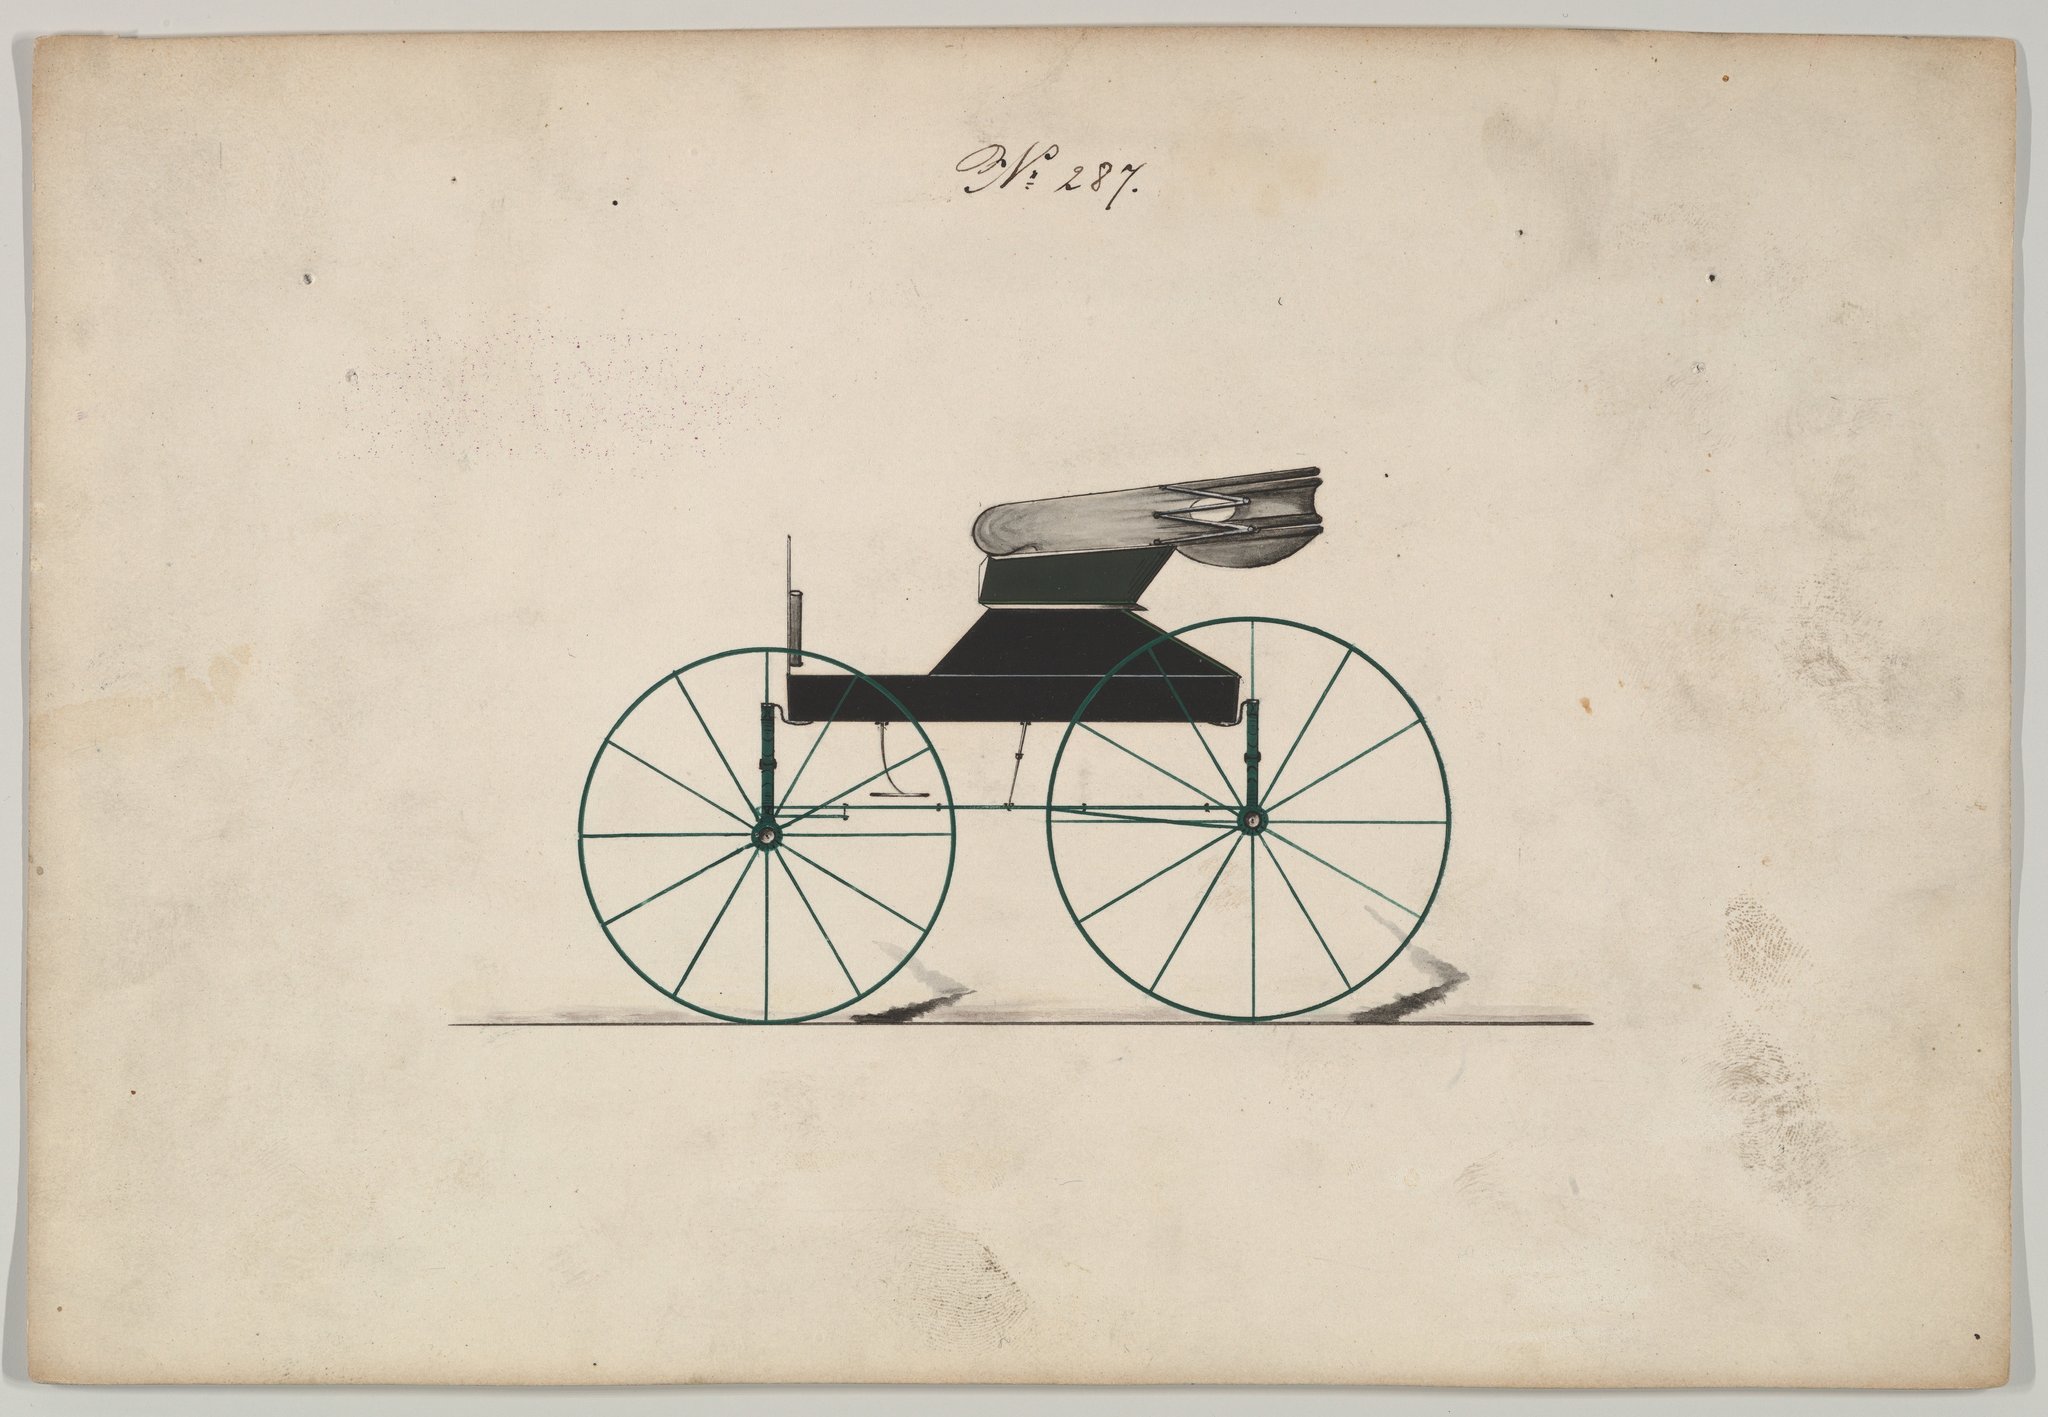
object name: drawing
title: Wagon #287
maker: brewster & co.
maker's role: manufacturer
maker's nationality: american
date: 1865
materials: gouache, ink, watercolor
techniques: pen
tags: carriages